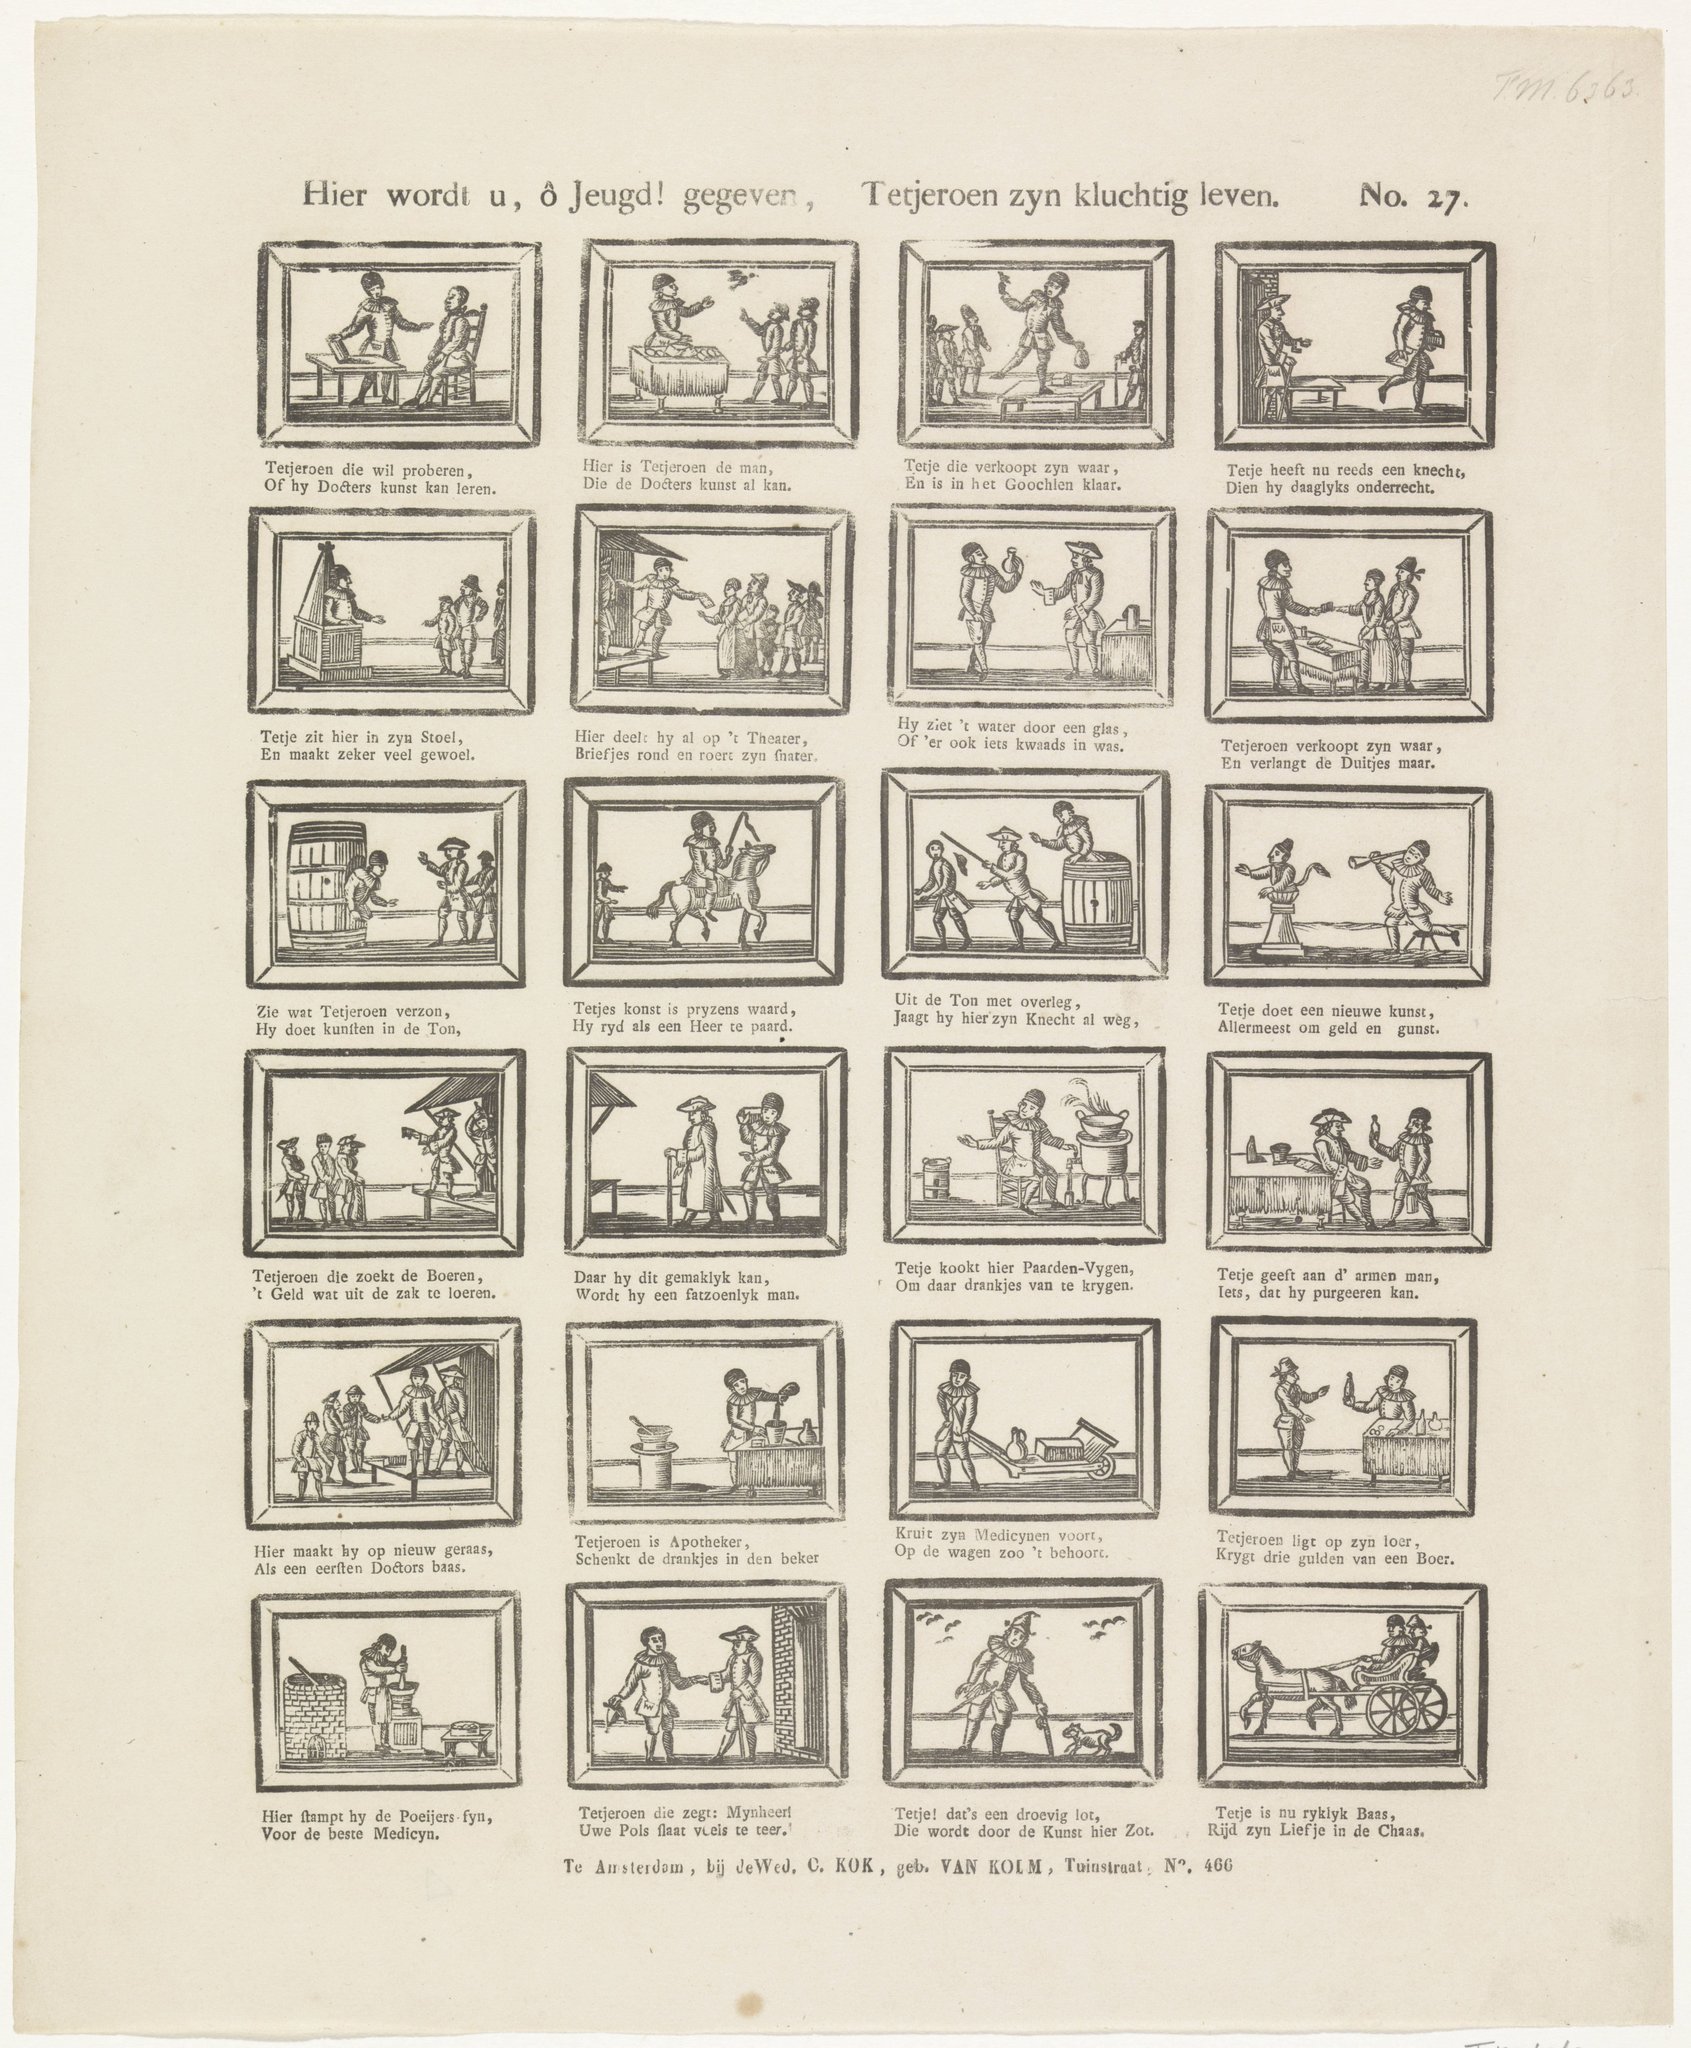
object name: print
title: Hier wordt u, ô Jeugd! gegeven, Tetjeroen zyn kluchtig leven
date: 1800-1850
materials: paper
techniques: letterpress printing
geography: netherlands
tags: quack, charlatan, mountebank, 'saltimbanco'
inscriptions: collector's mark: Lugt 2228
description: Blad met 24 voorstellingen over het leven van de kwakzalver en grappenmaker Tetjeroen. Hij gaat in de leer bij een dokter, klopt boeren geld uit de zak, kookt drankjes van paardenvijgen en gaat met zijn liefje in een koets rijden. Onder elk plaatje een tweeregelig versje. Ca. 1800-1850. Genummerd rechtsboven: No. 27.